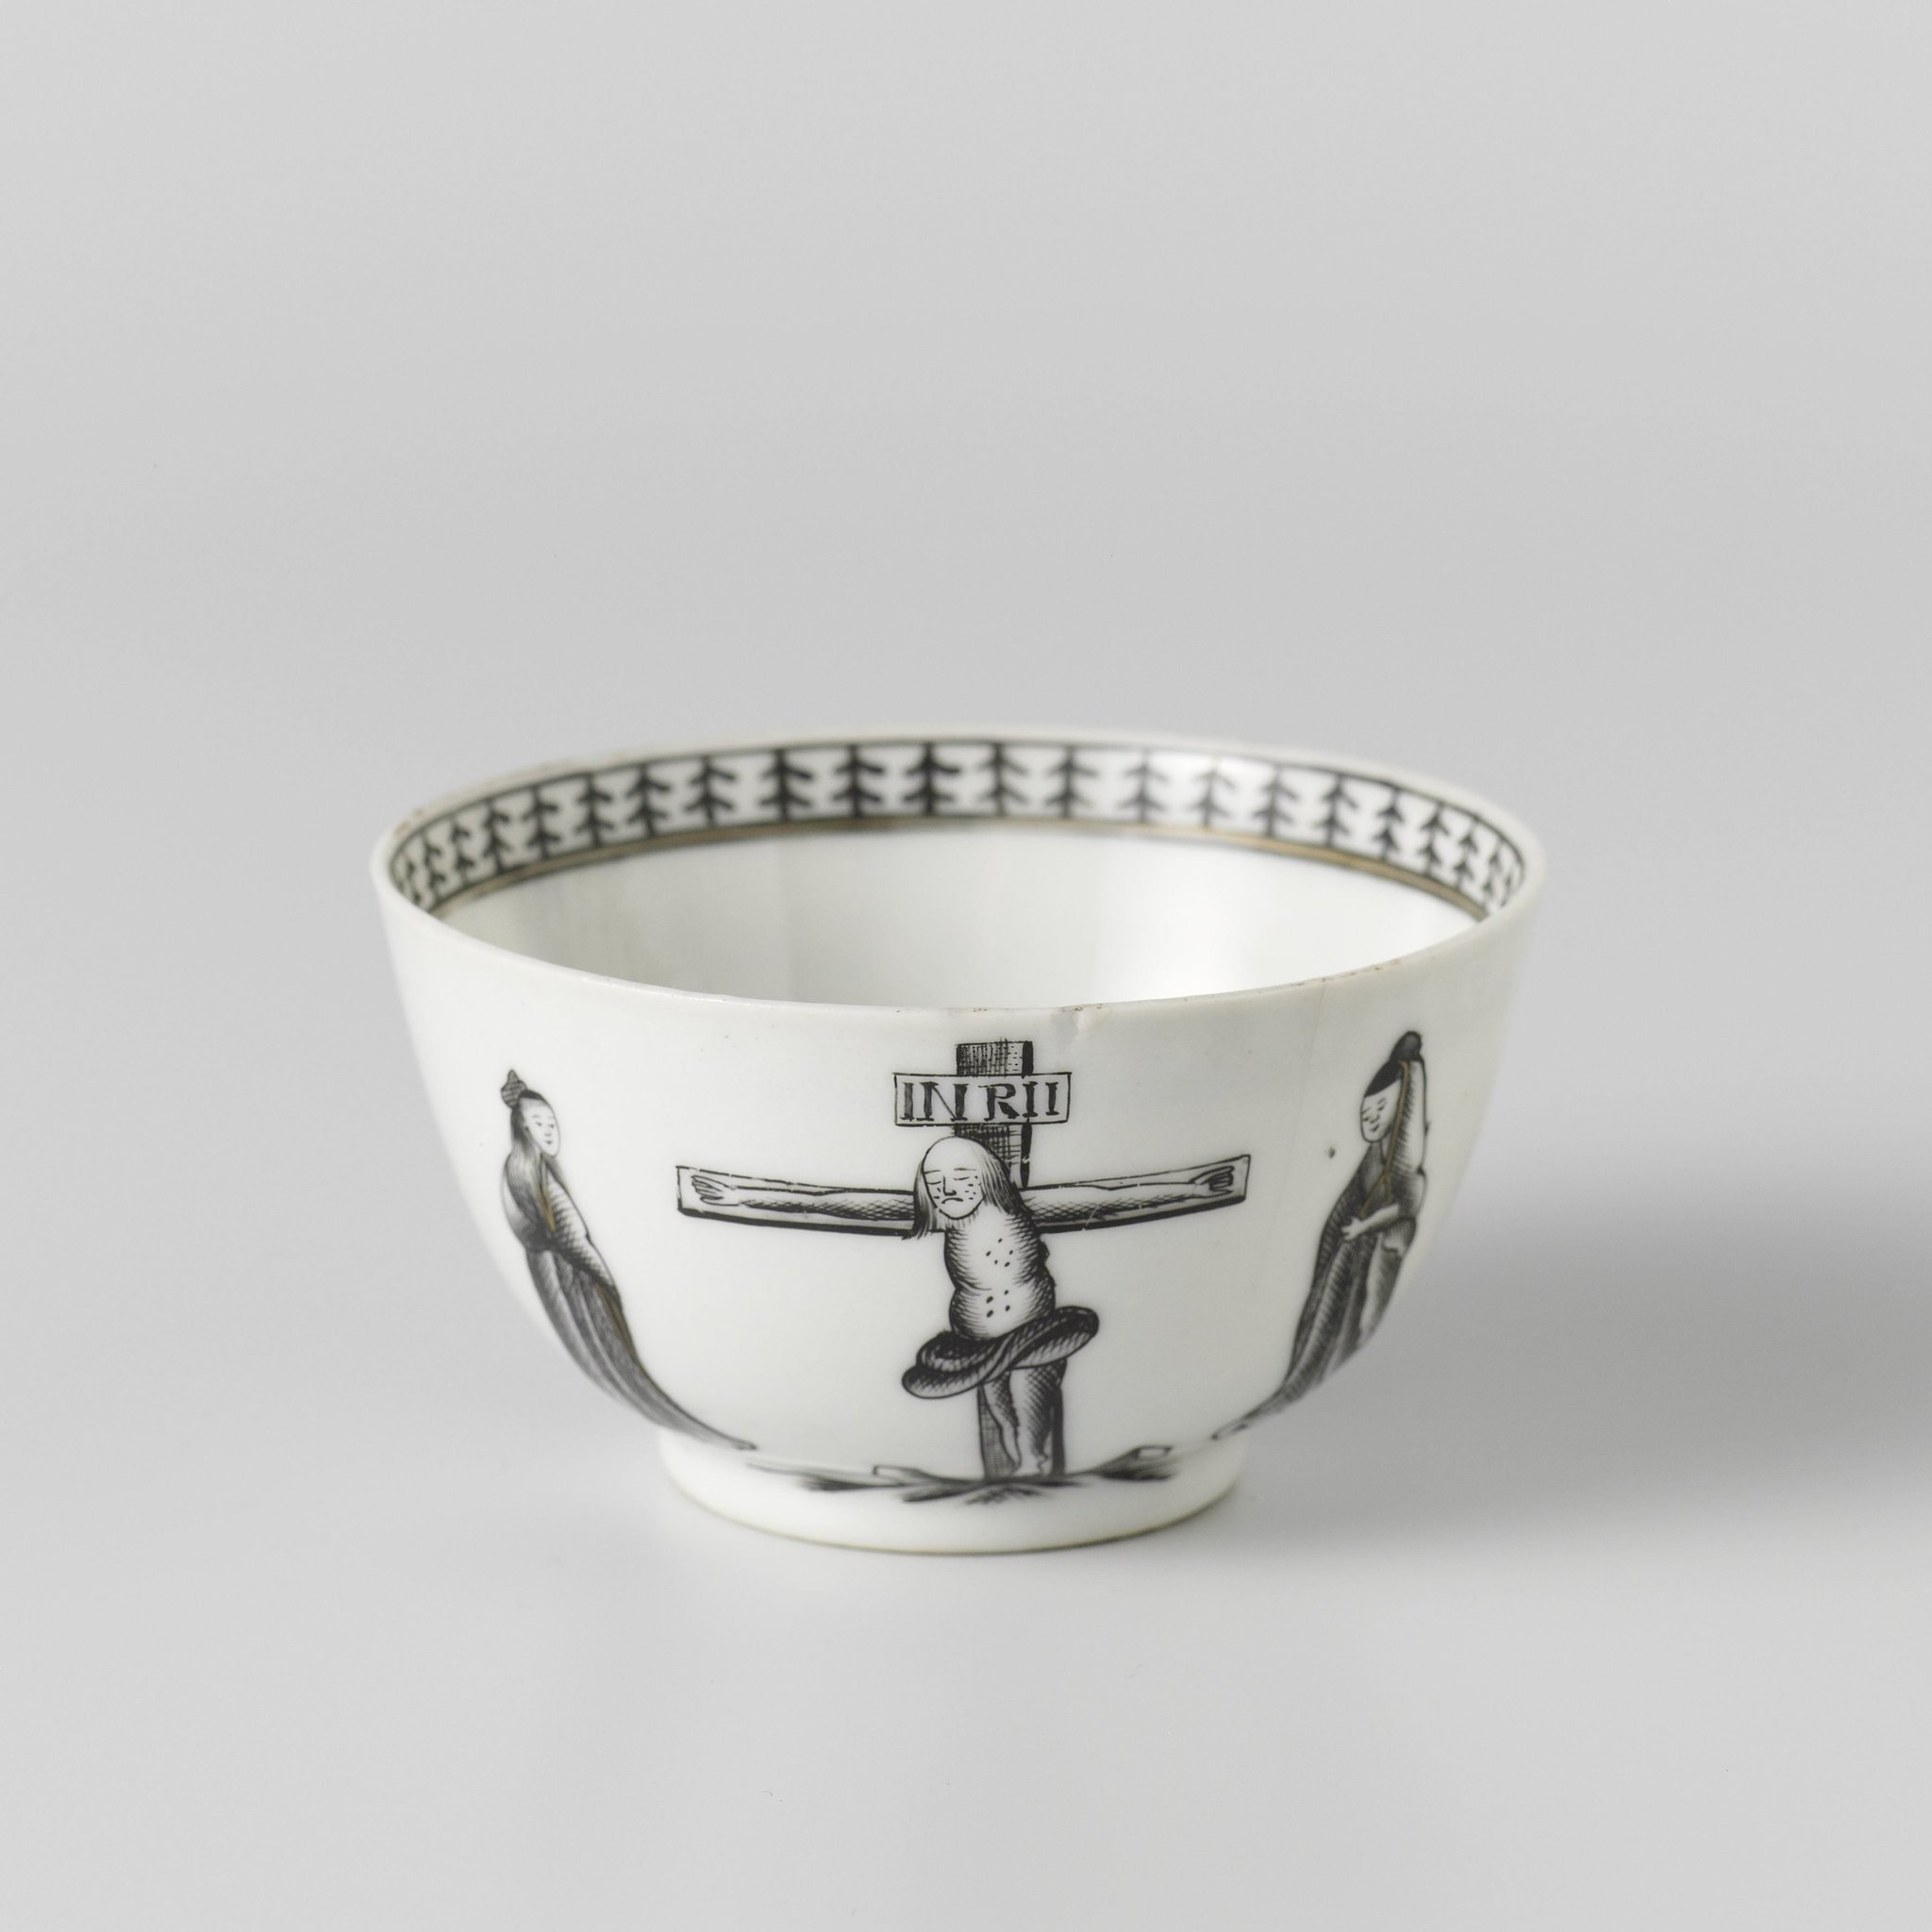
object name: cup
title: Bell-shaped cup with a crucifixion scene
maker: Anonymous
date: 1780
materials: glaze, gold, paint, porcelain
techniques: firing, gilding, turning, vitrification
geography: china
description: Kop op voetring, gedecoreerd in encre de Chine en goud met een voorstelling van de Kruisiging. Behorend tot theeservies.